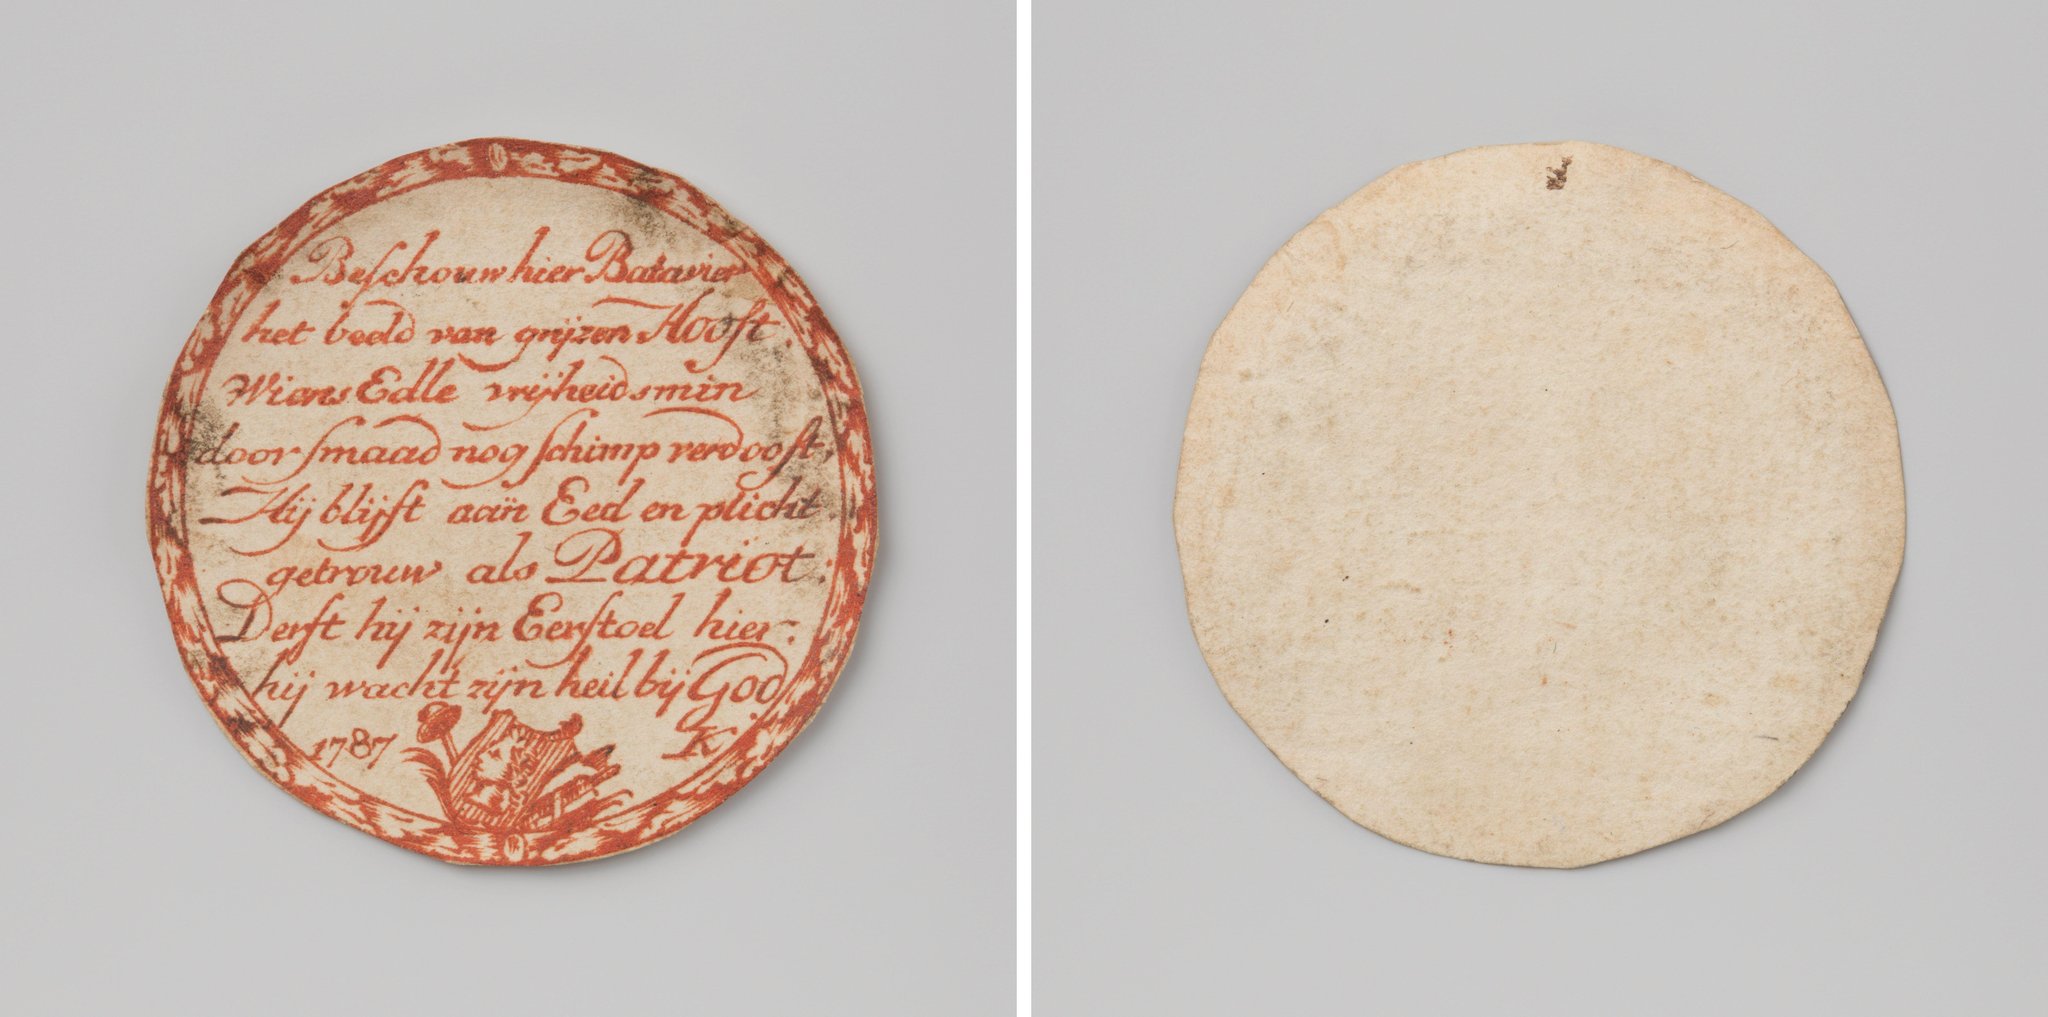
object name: print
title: Hendrik Danielsz. Hooft, burgemeester van Amsterdam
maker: Anonymous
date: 1787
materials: cardboard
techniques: printing, snipping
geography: netherlands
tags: amsterdam, hendrik danielsz. hooft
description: eenzijdige afbeelding in rode inkt van keerzijde van draagteken, voorstellende opschrift boven ereteken, bestaande uit wapenschild, vrijheidshoed op speer, roedebundel met bijl en palmtak binnen eikekrans